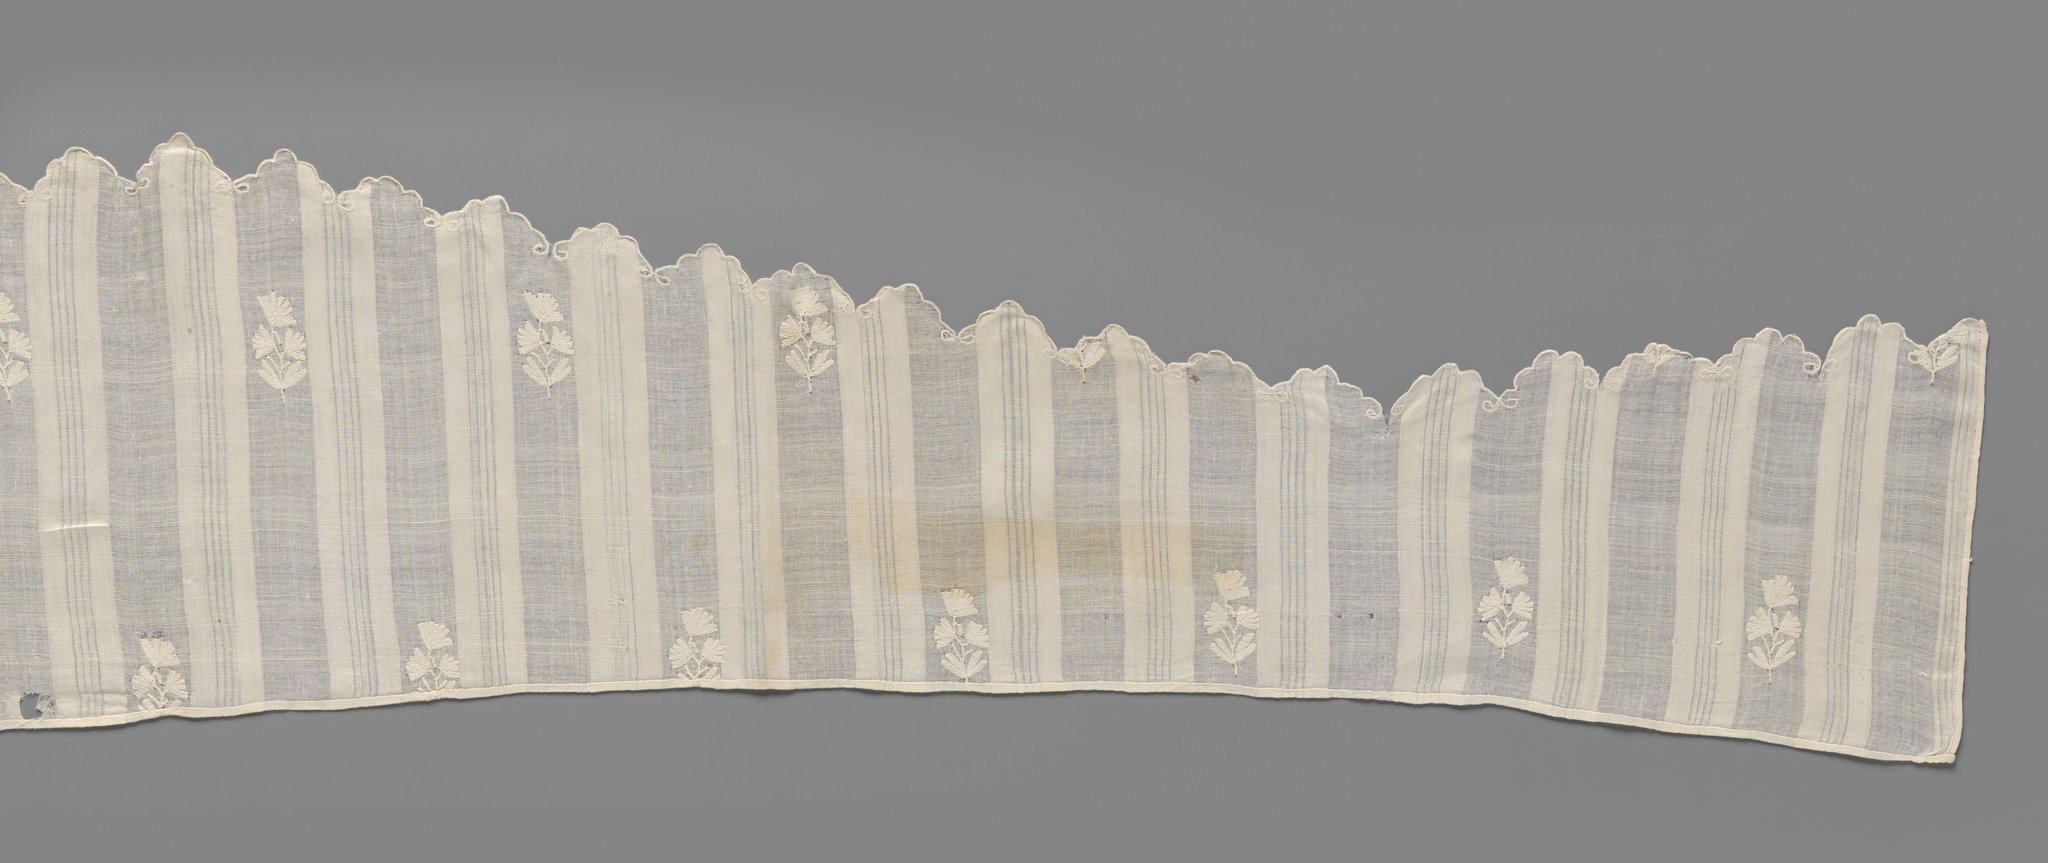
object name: strip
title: Strook batist met ingeweven strepen en twee rijen geborduurde takjes met elk drie bloemen en een golvende rand met schulpen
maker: Anonymous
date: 1800-1899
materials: textile, linen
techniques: embroidered, weave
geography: western europe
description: Strook naturelkleurige batist met ingeweven verticale strepen en borduurwerk. Het borduurwerk bestaat uit twee rijen hangende takjes met elk twee hartvormige blaadjes en drie waaiervormige bloemen. De twee rijen zijn niet compleet. De bovenste rij is halverwege doorgeknipt, het batist is hier afgewerkt met een zoompje. De strook is langs de onderzijde in twee grote golven geknipt waardoor sommige geborduurde takjes ook (deels) wegvallen. Langs de onderzijde loopt bovendien een schulpenrand van min of meer driehoekige schulpen met elk vijf vlakke geborduurde lobjes. In de strook zit halverwege een (verticale) naad. De strook is mogelijk gebruikt of bedoeld als engageante.